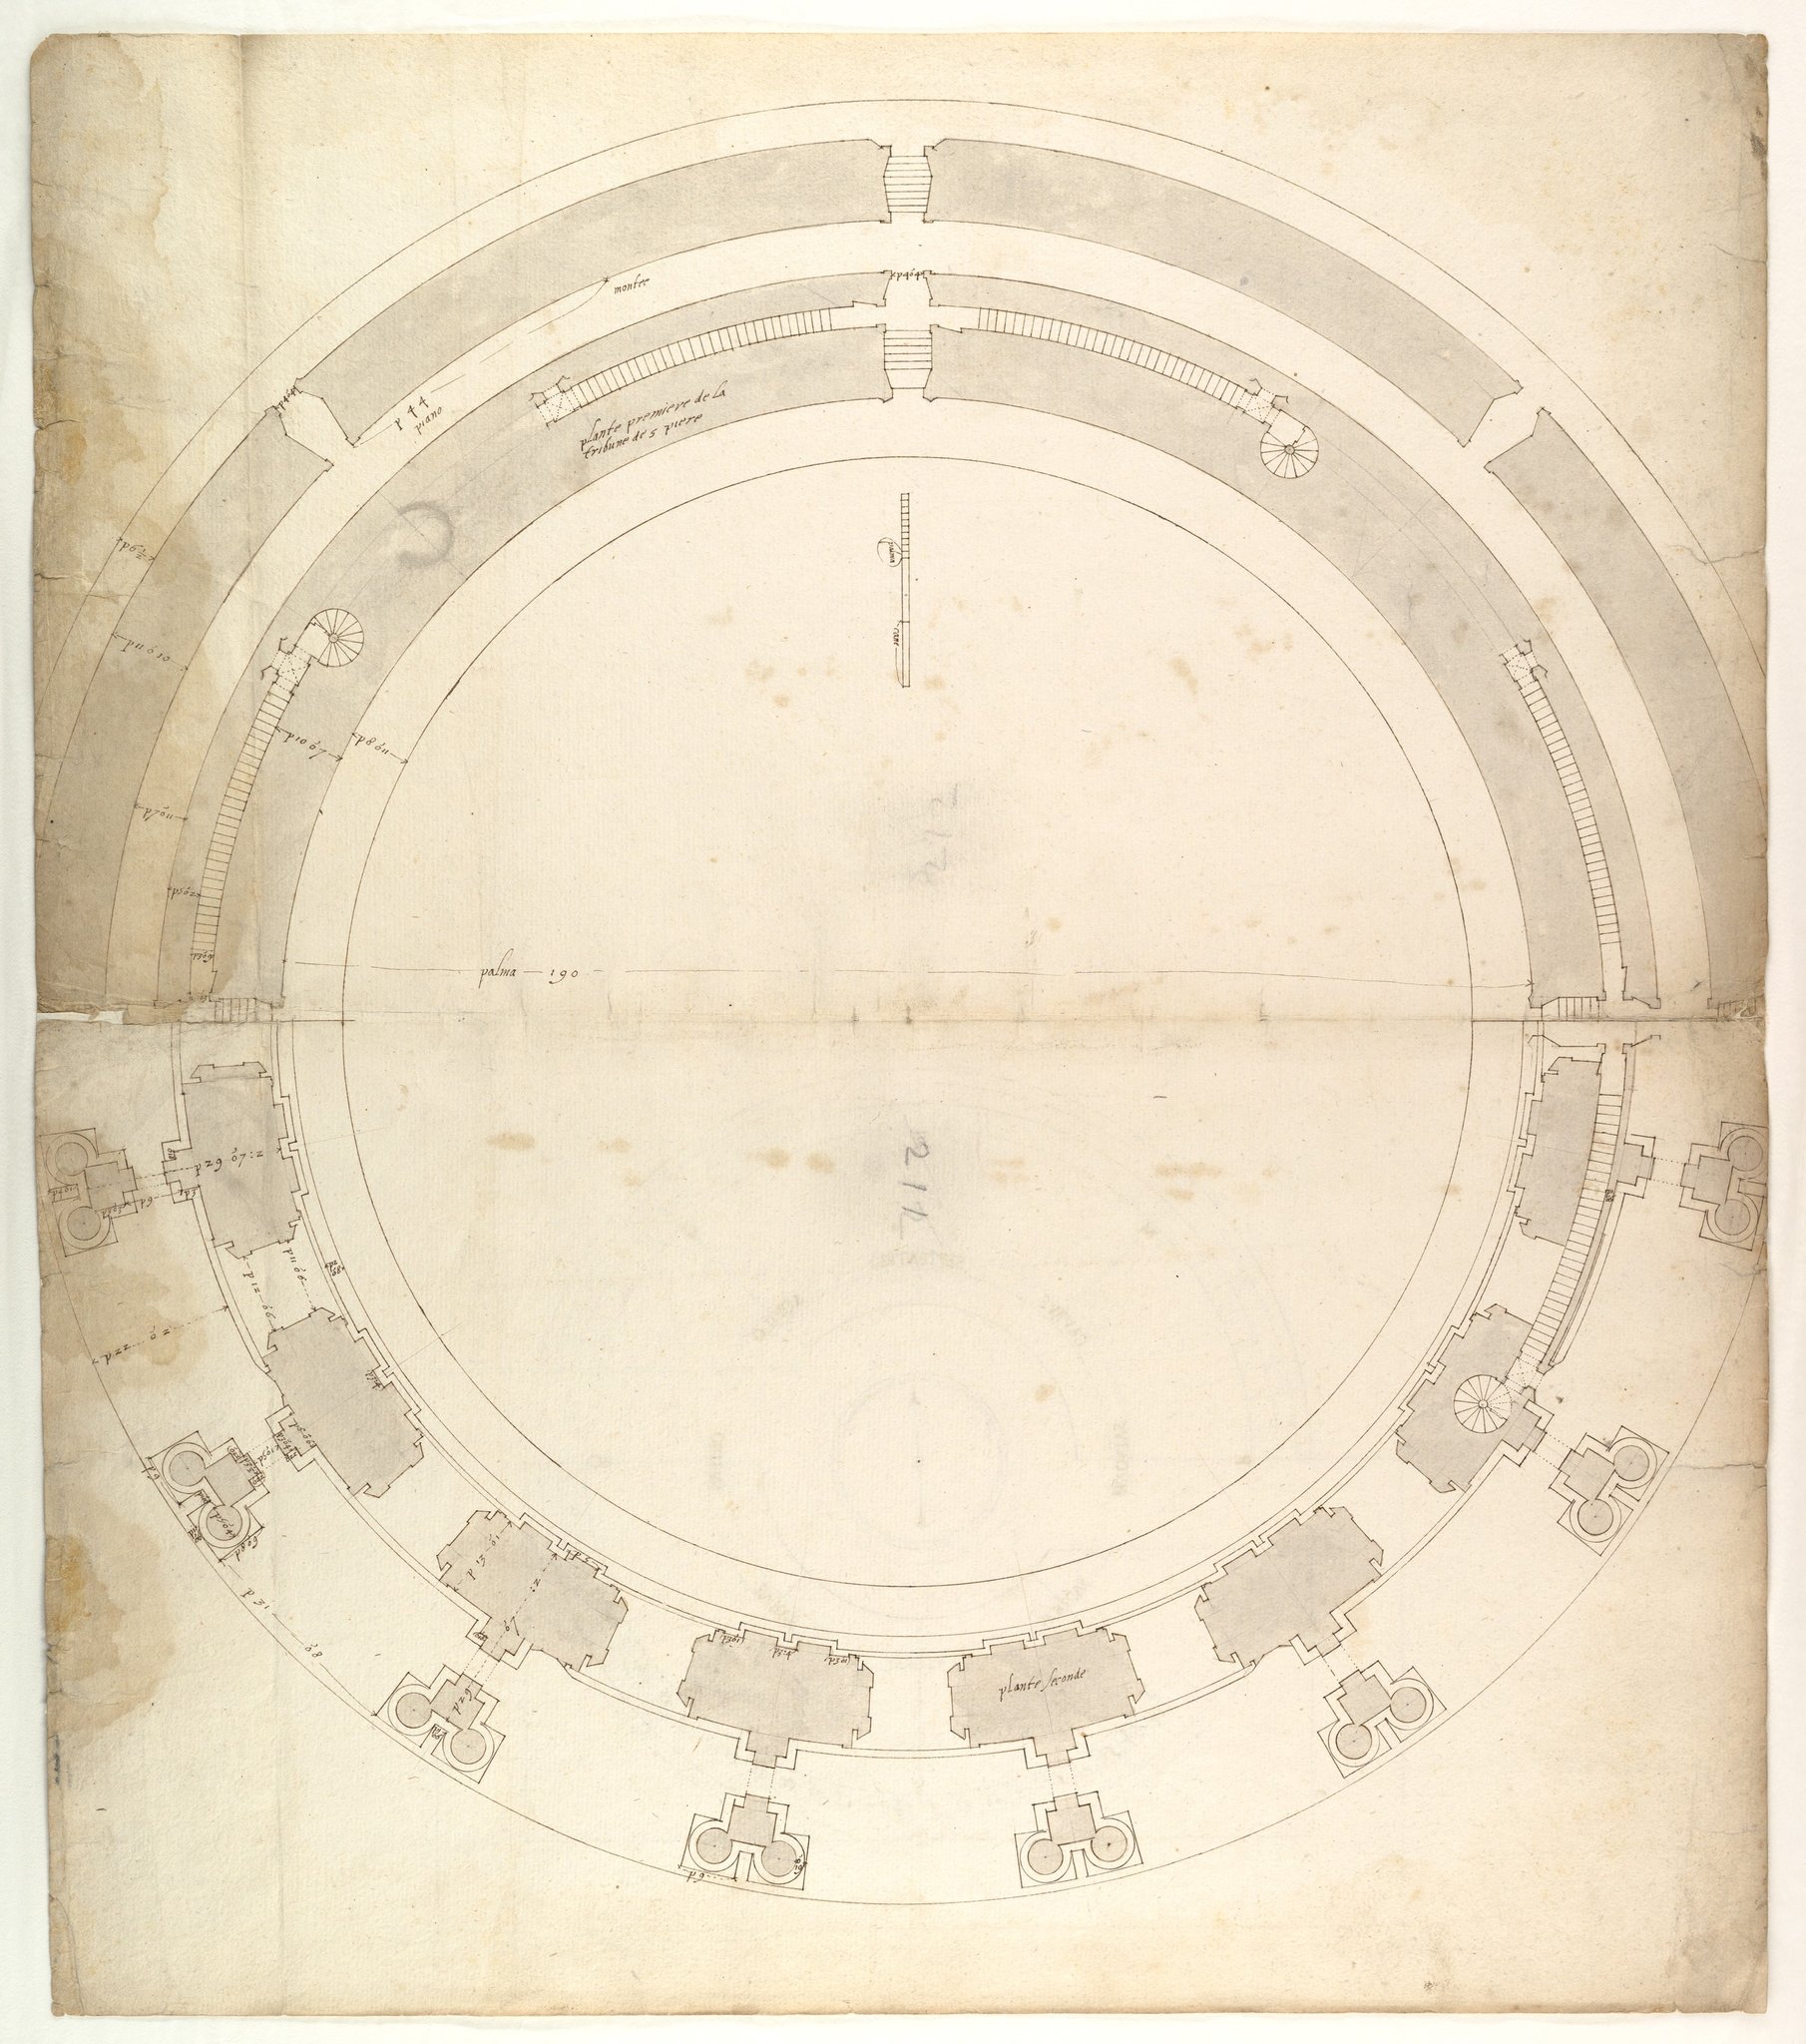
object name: drawing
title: St. Peter's, drum, plan, at two levels (recto) compass (verso)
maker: anonymous, french, 16th century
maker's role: draftsman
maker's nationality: french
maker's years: 1500-1600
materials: chalk, ink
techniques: incising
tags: architecture